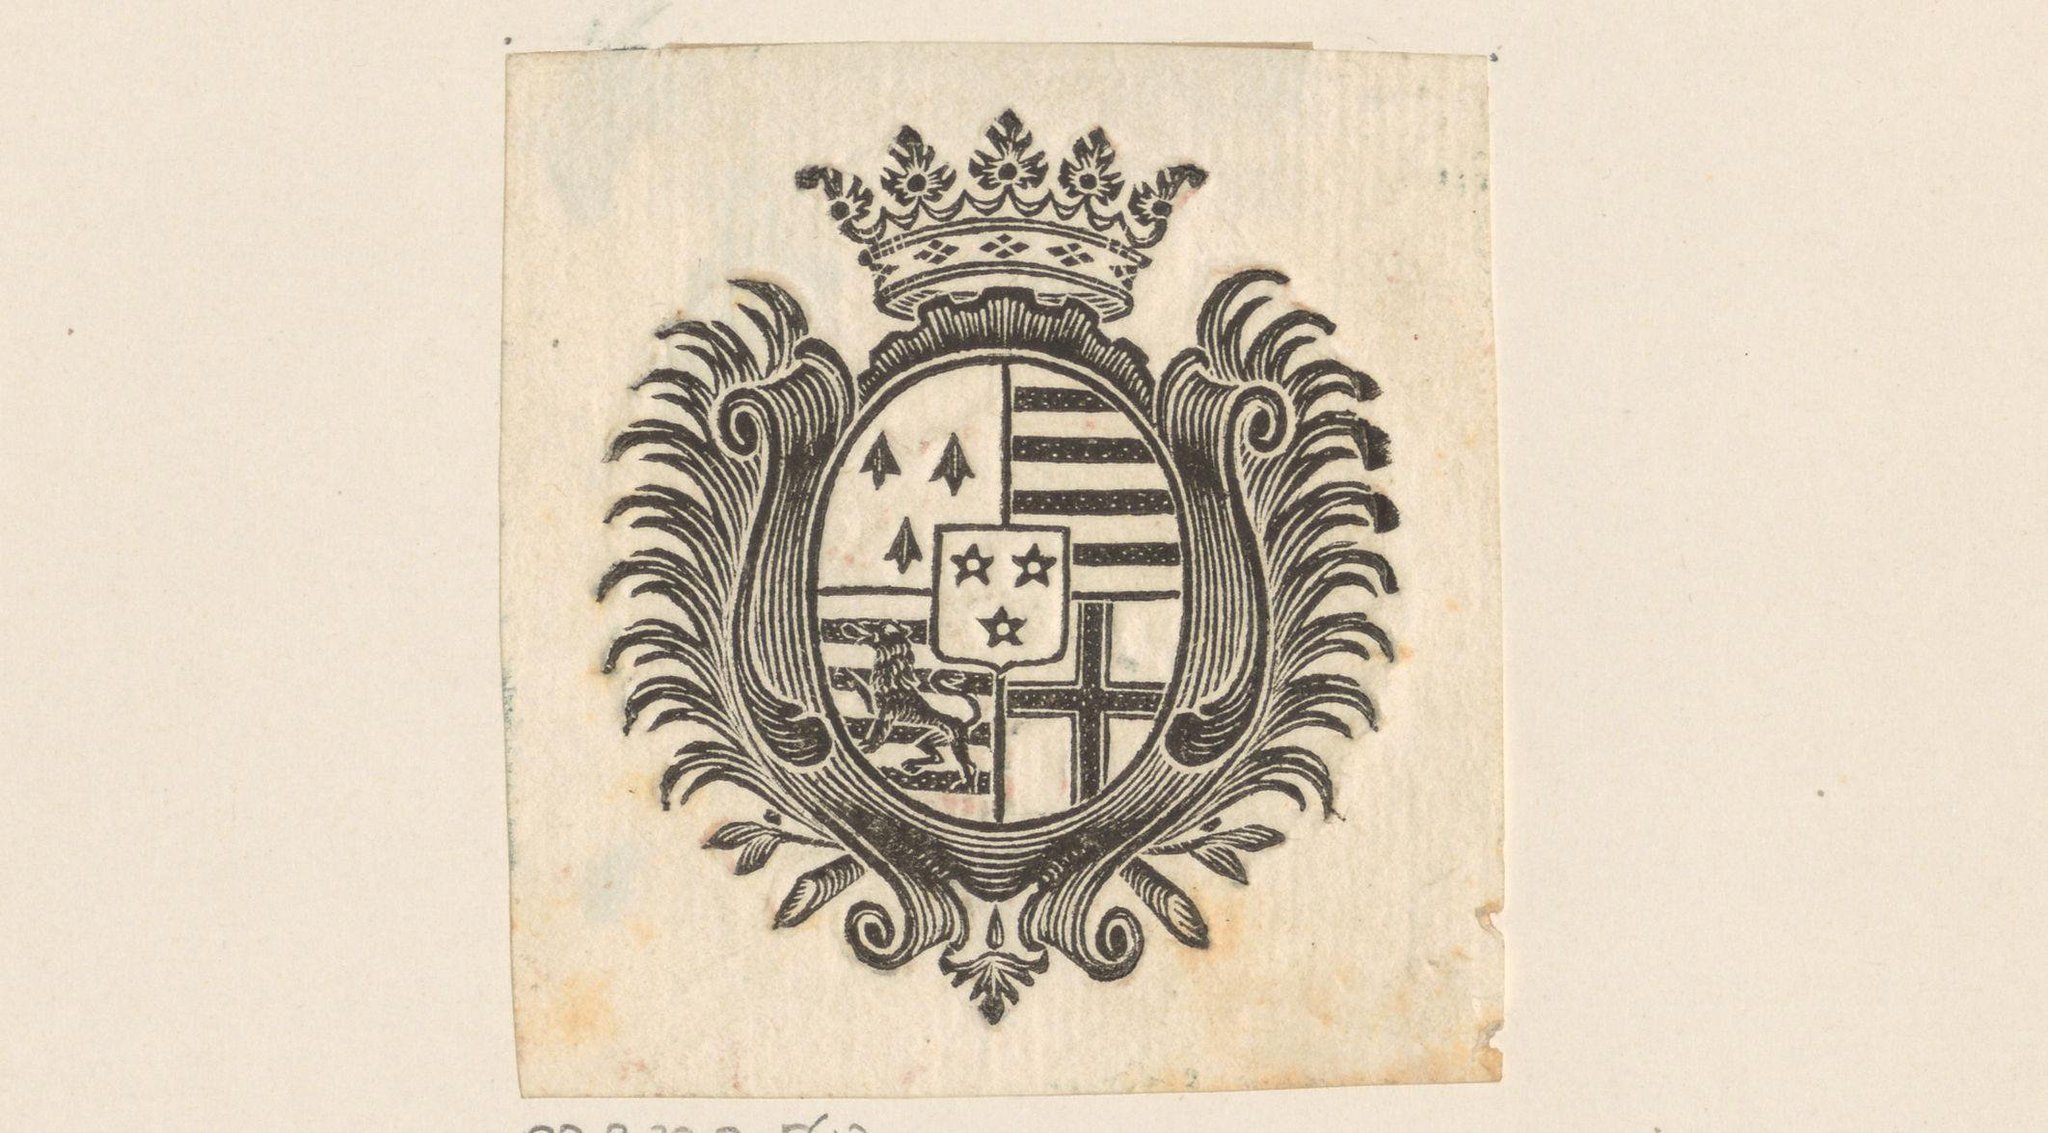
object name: bookplate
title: Ex libris van onbekend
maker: Anonymous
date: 1750-1899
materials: paper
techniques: woodcut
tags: armorial bearing, heraldry